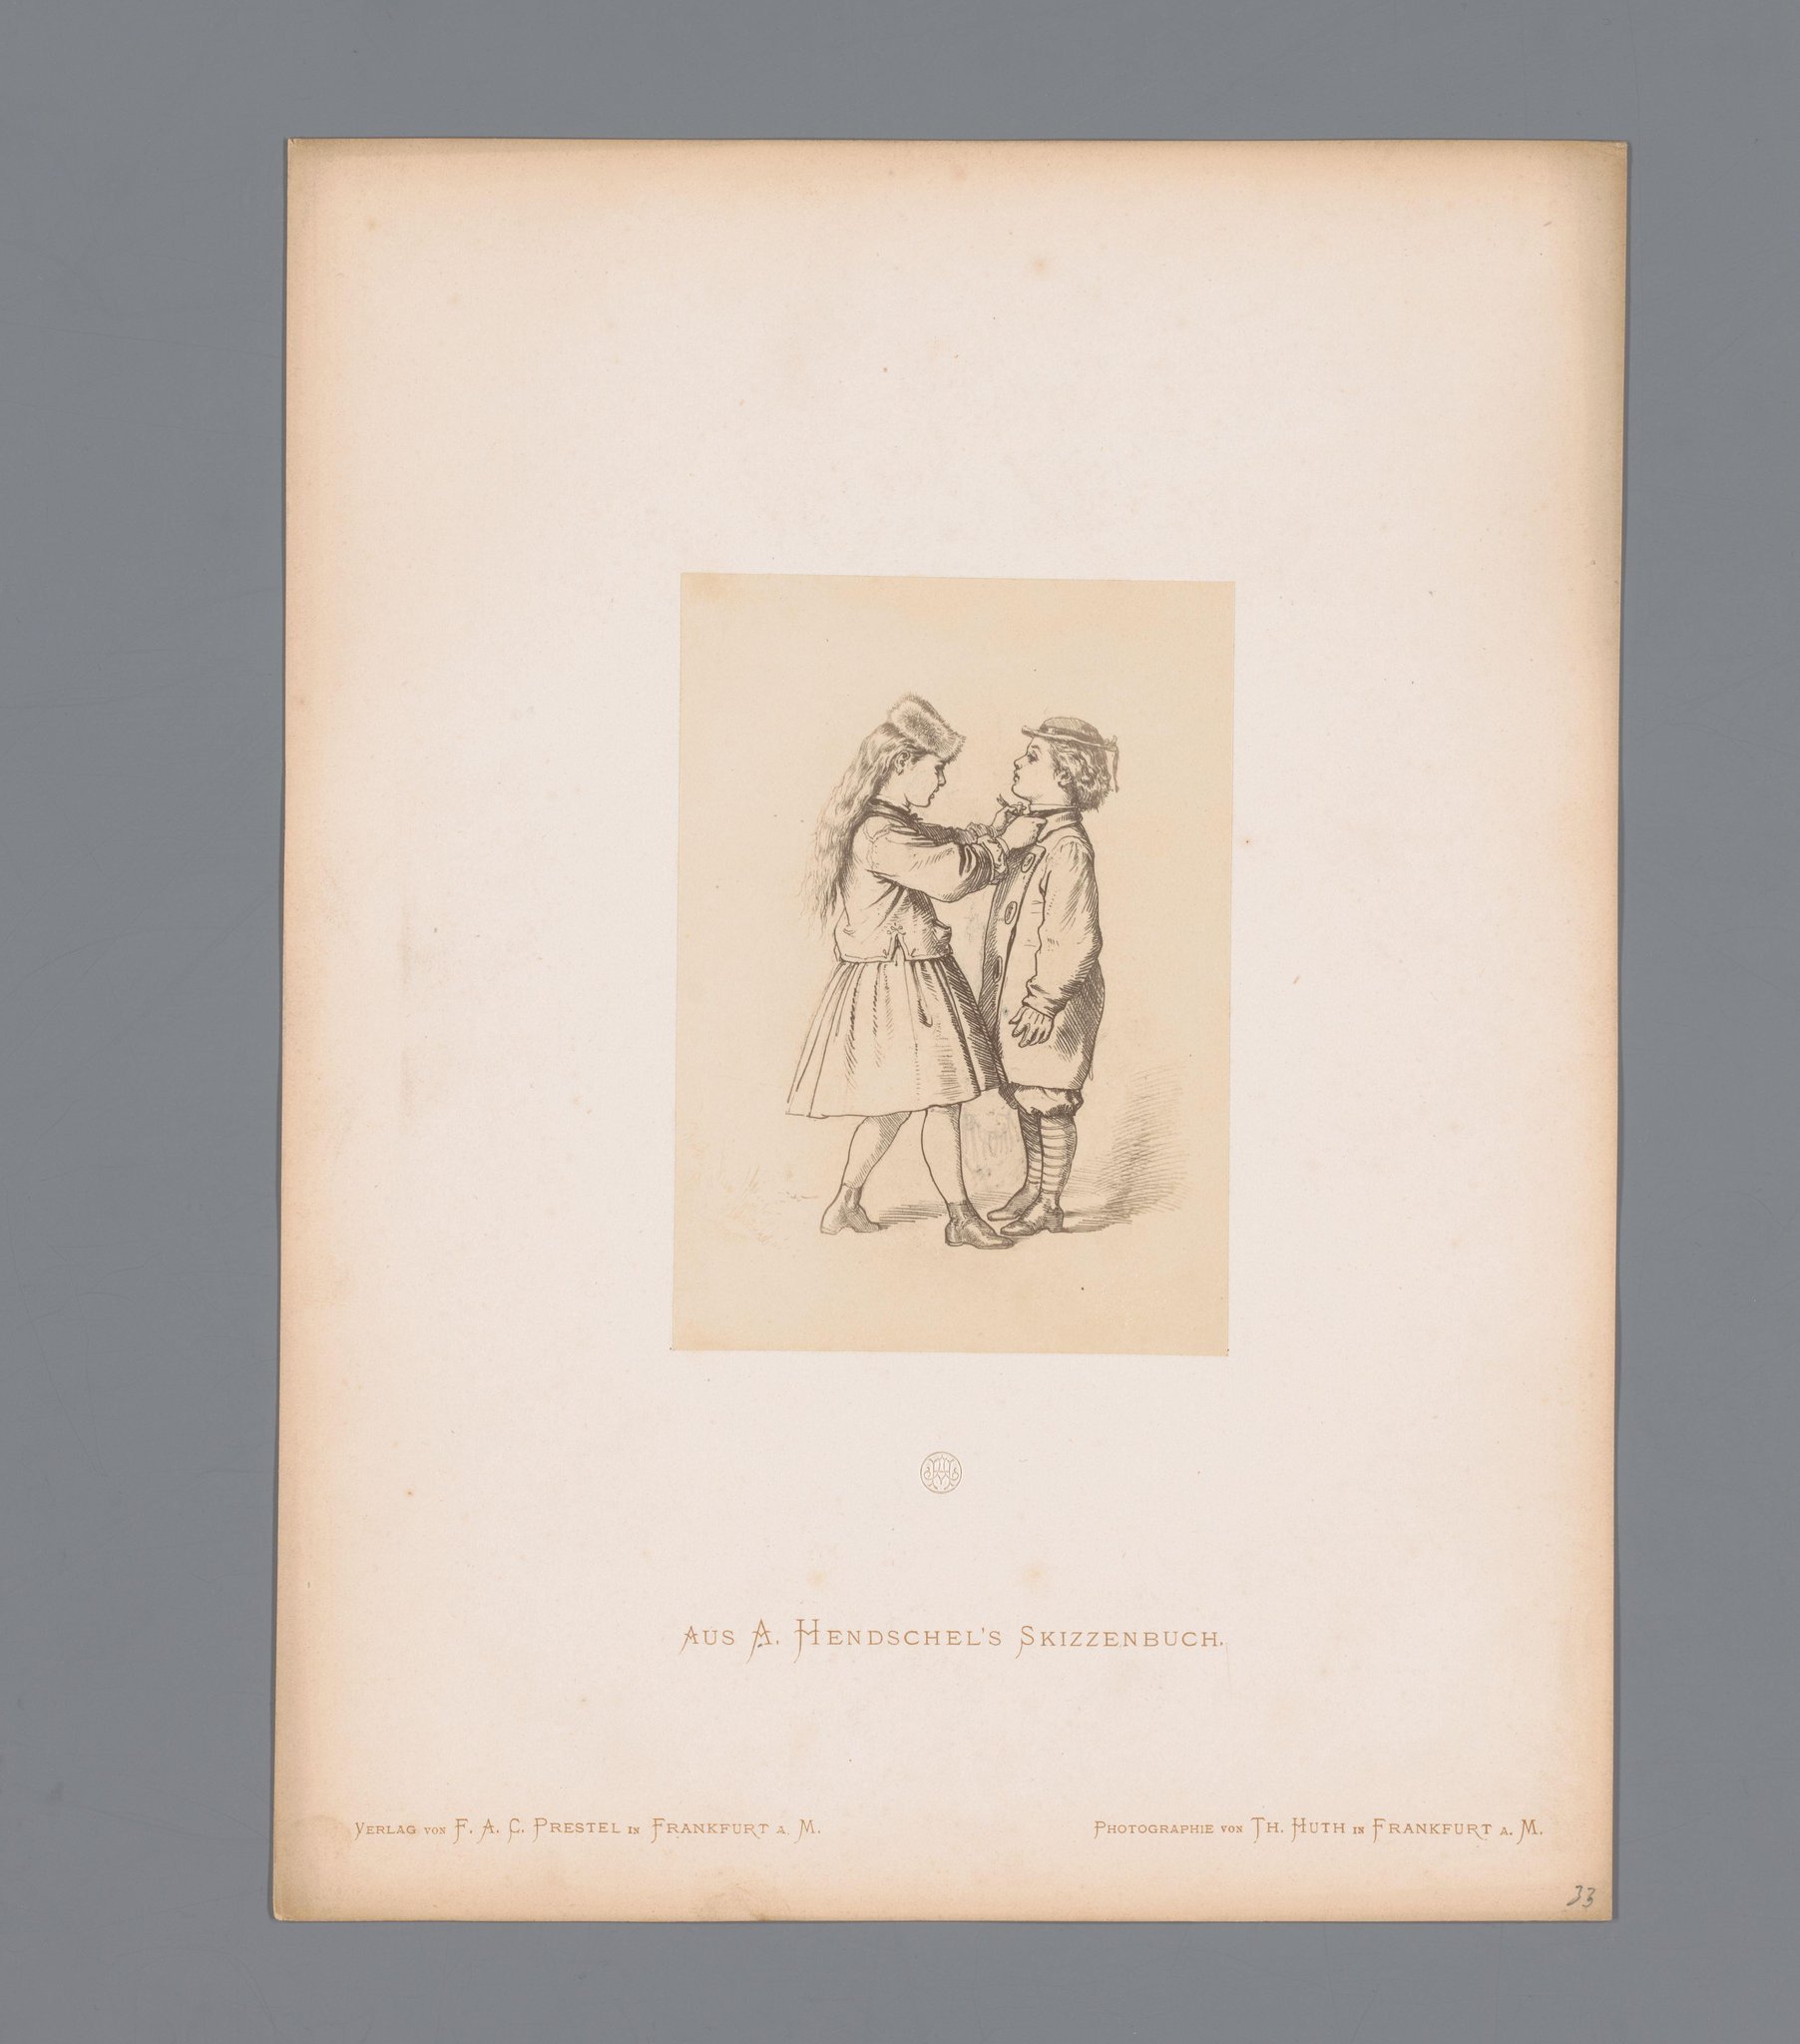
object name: reproduction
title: Fotoreproductie van een schets van twee kinderen door Albert Hendschel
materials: photographic support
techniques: albumen print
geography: frankfurt am main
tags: child (+ two persons)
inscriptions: number: ‘33’, monogram: ‘AH’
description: Deze foto maakt deel uit van een omslag met 50 foto's op 48 bladen, een lijst van afbeeldingen en een titelblad.